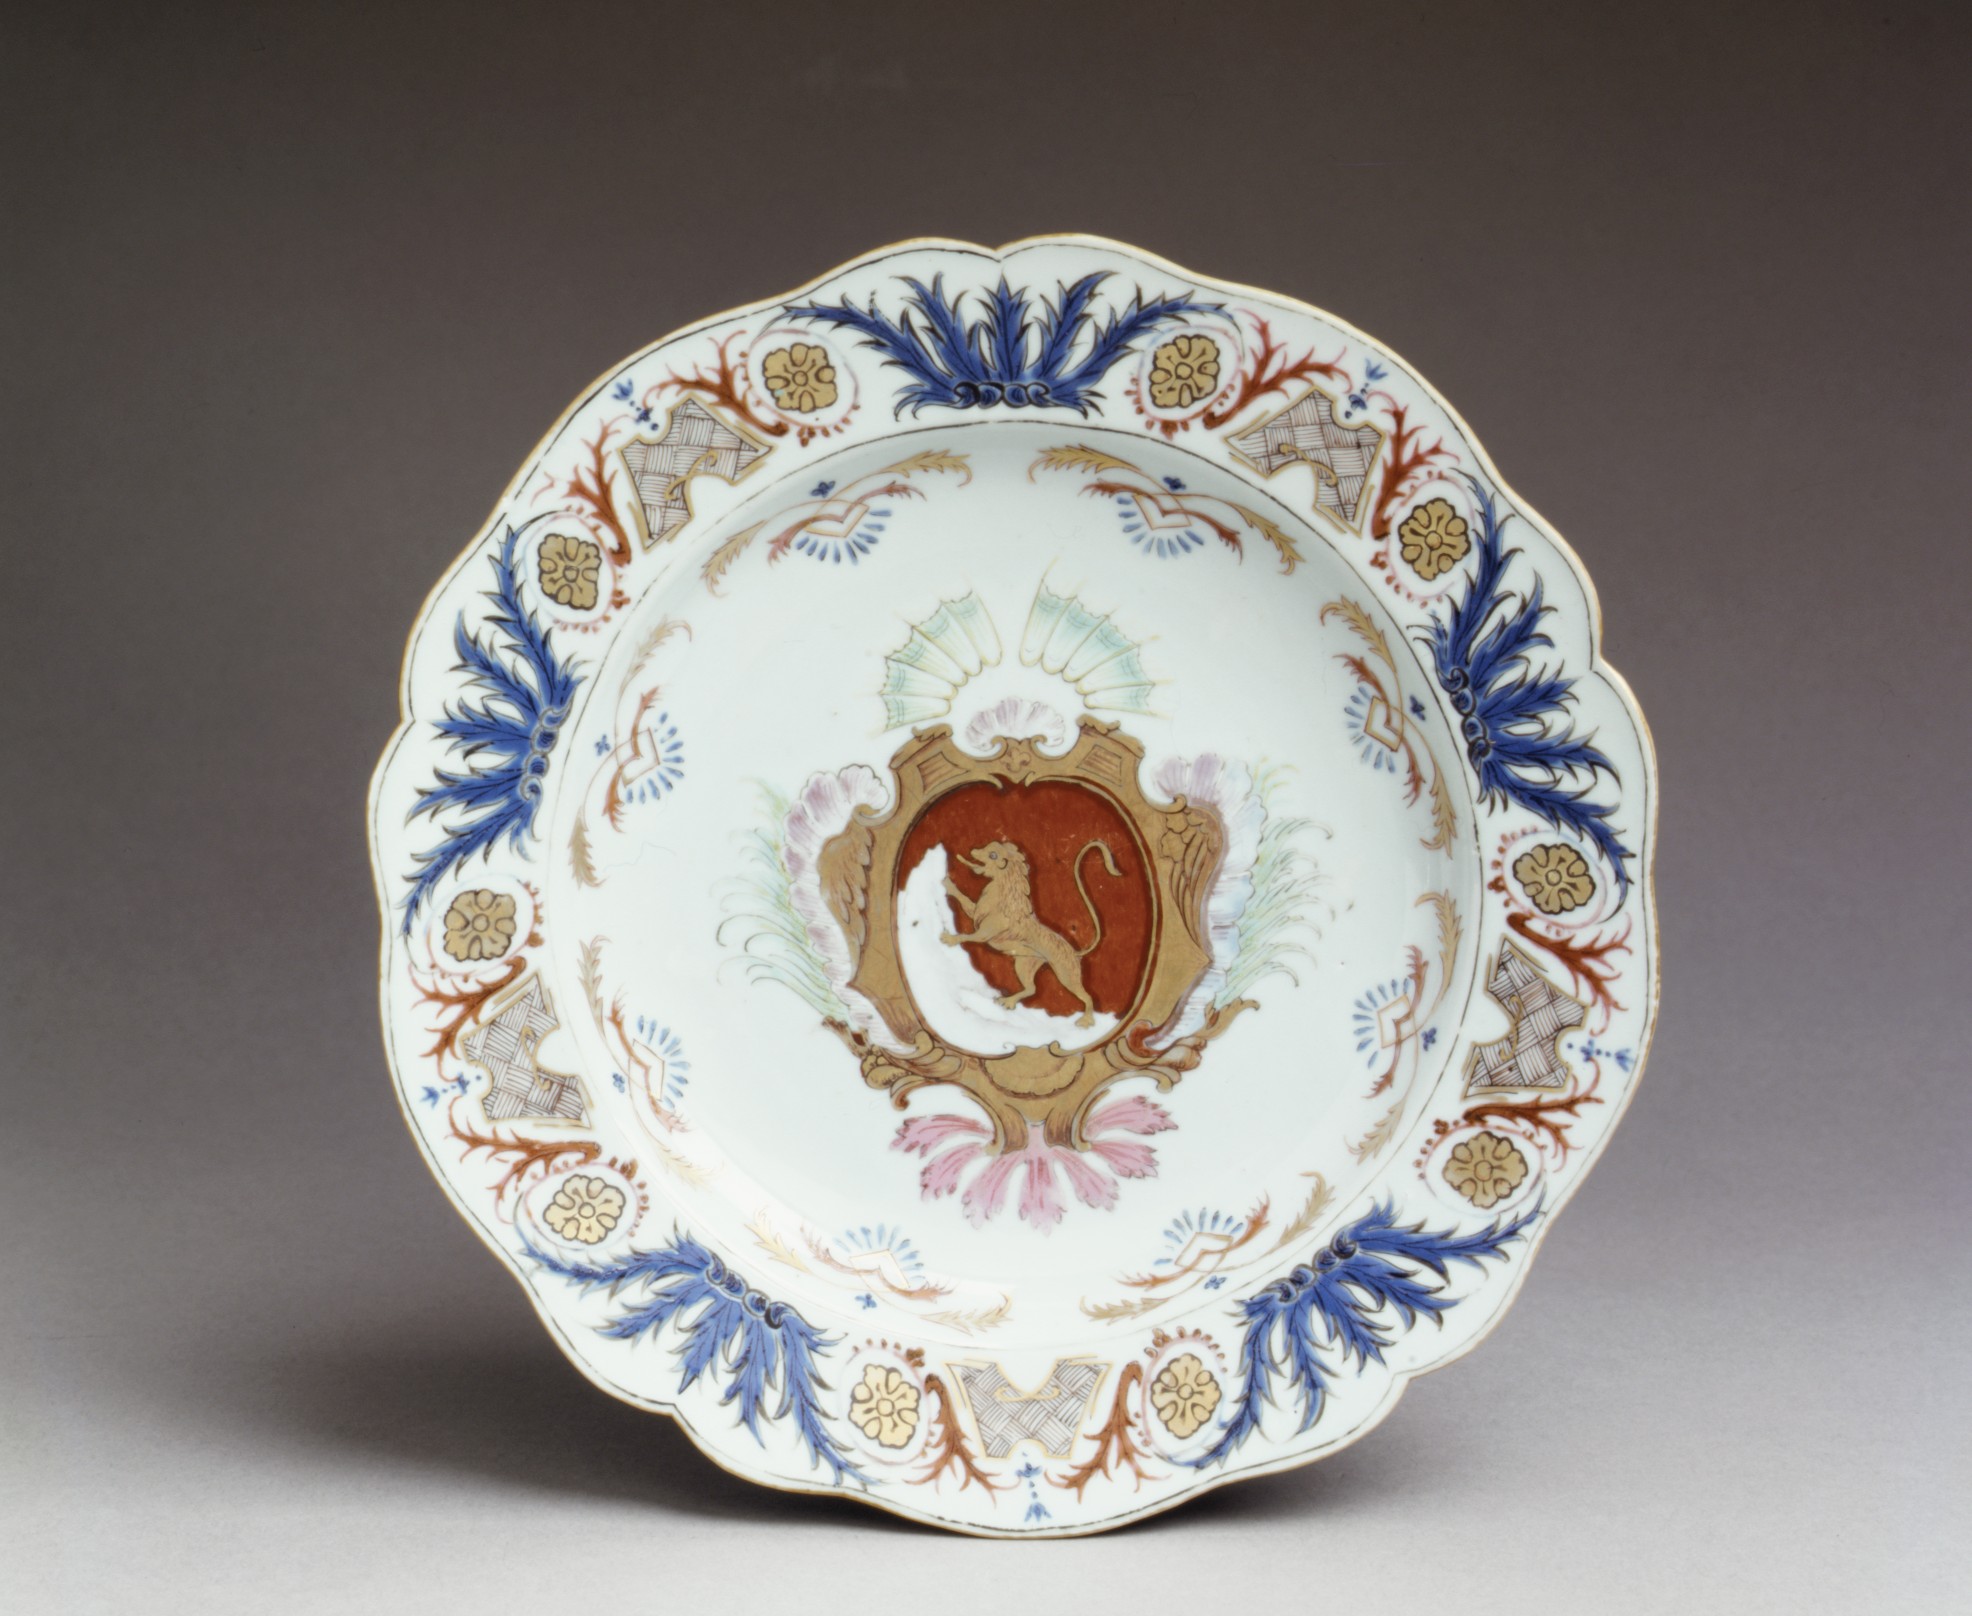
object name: plate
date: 1740-1750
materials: hard paste porcelain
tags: coat of arms